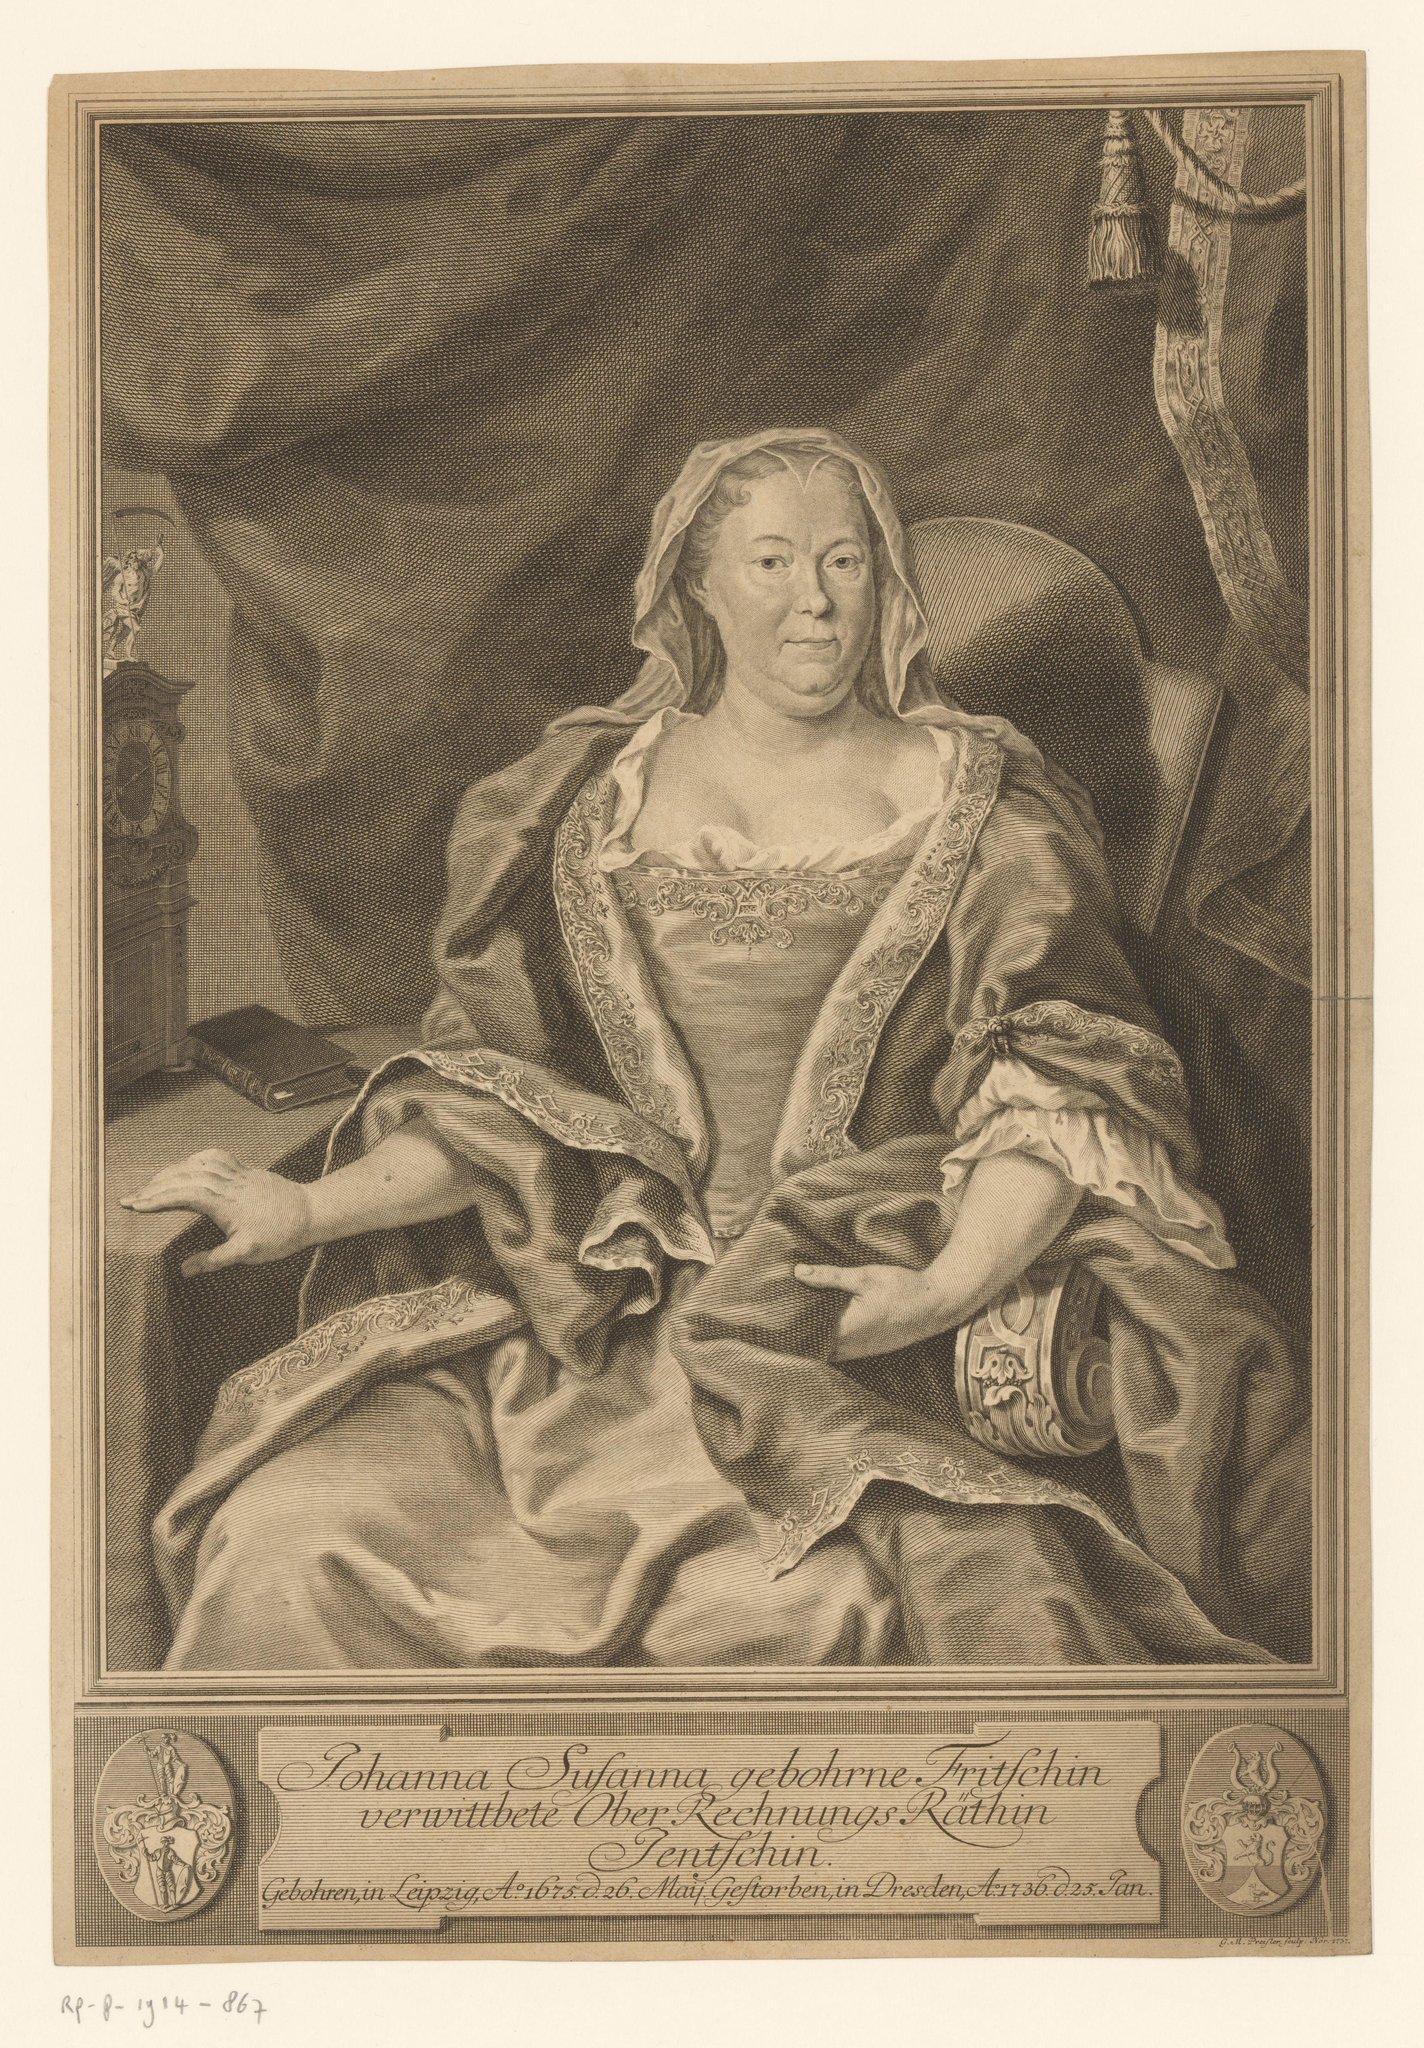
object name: print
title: Portret van Johanna Susanna Jentzsch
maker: georg martin preissler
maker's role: print maker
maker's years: 1700-1754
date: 1737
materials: paper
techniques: engraving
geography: nuremberg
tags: historical persons - bb - woman, book, clock, armorial bearing, heraldry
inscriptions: collector's mark: Lugt 2228